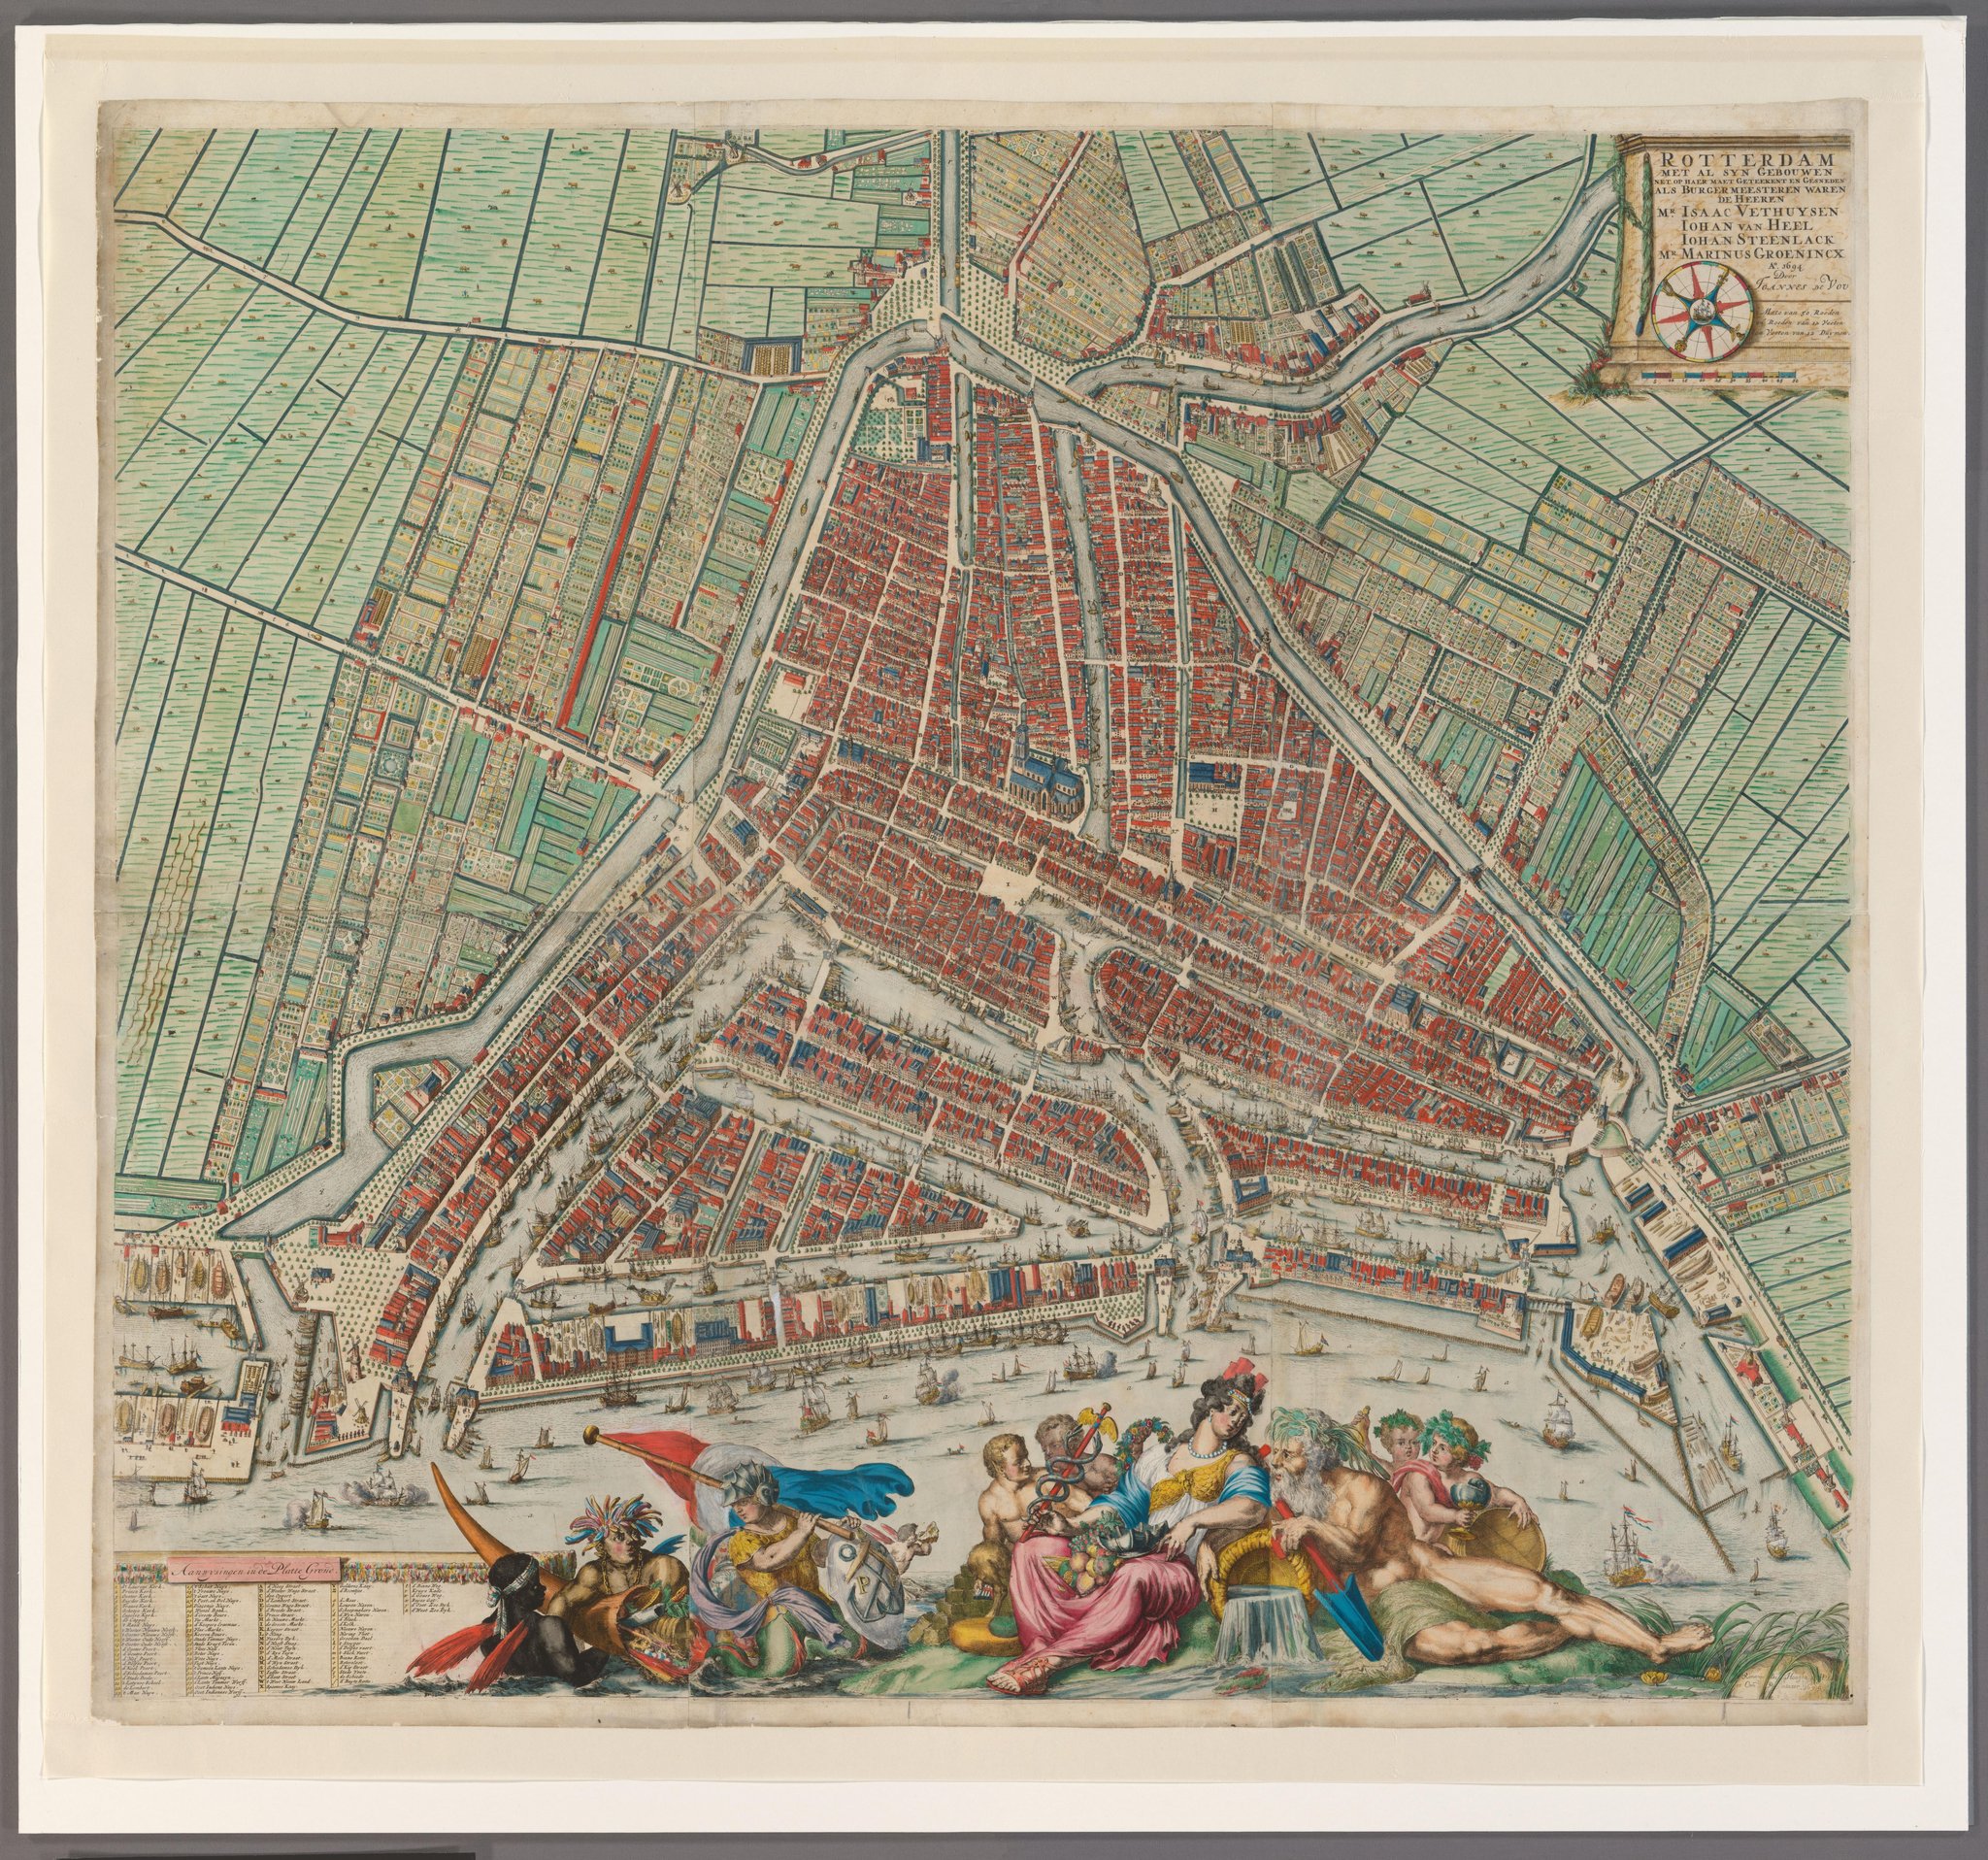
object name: print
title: Rotterdam met al syn gebouwen net op haer maet geteekent en gesneden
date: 1694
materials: paper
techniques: etching, hand coloring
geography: rotterdam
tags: 'cornucopia', horn of plenty, merman, river-gods, satyr(s) (in general), maps of cities, flag, colours (as symbol of the state, etc.), rotterdam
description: Plattegrond in vogelvluchtperspectief. Linksonder de legenda 1-46, A-Z en a-z. Rechts daarvan een groep mythologische en allegorische figuren waaronder figuren en voorwerpen die verwijzen naar de overzeese handel, saters, de Rotterdamse stedenmaagd en een riviergod. Rechtsboven een cartouche met de titel, opdracht en een schaalstok: Mate van 50 roeden en roeden van 12 voeten en voeten van 12 duymen.